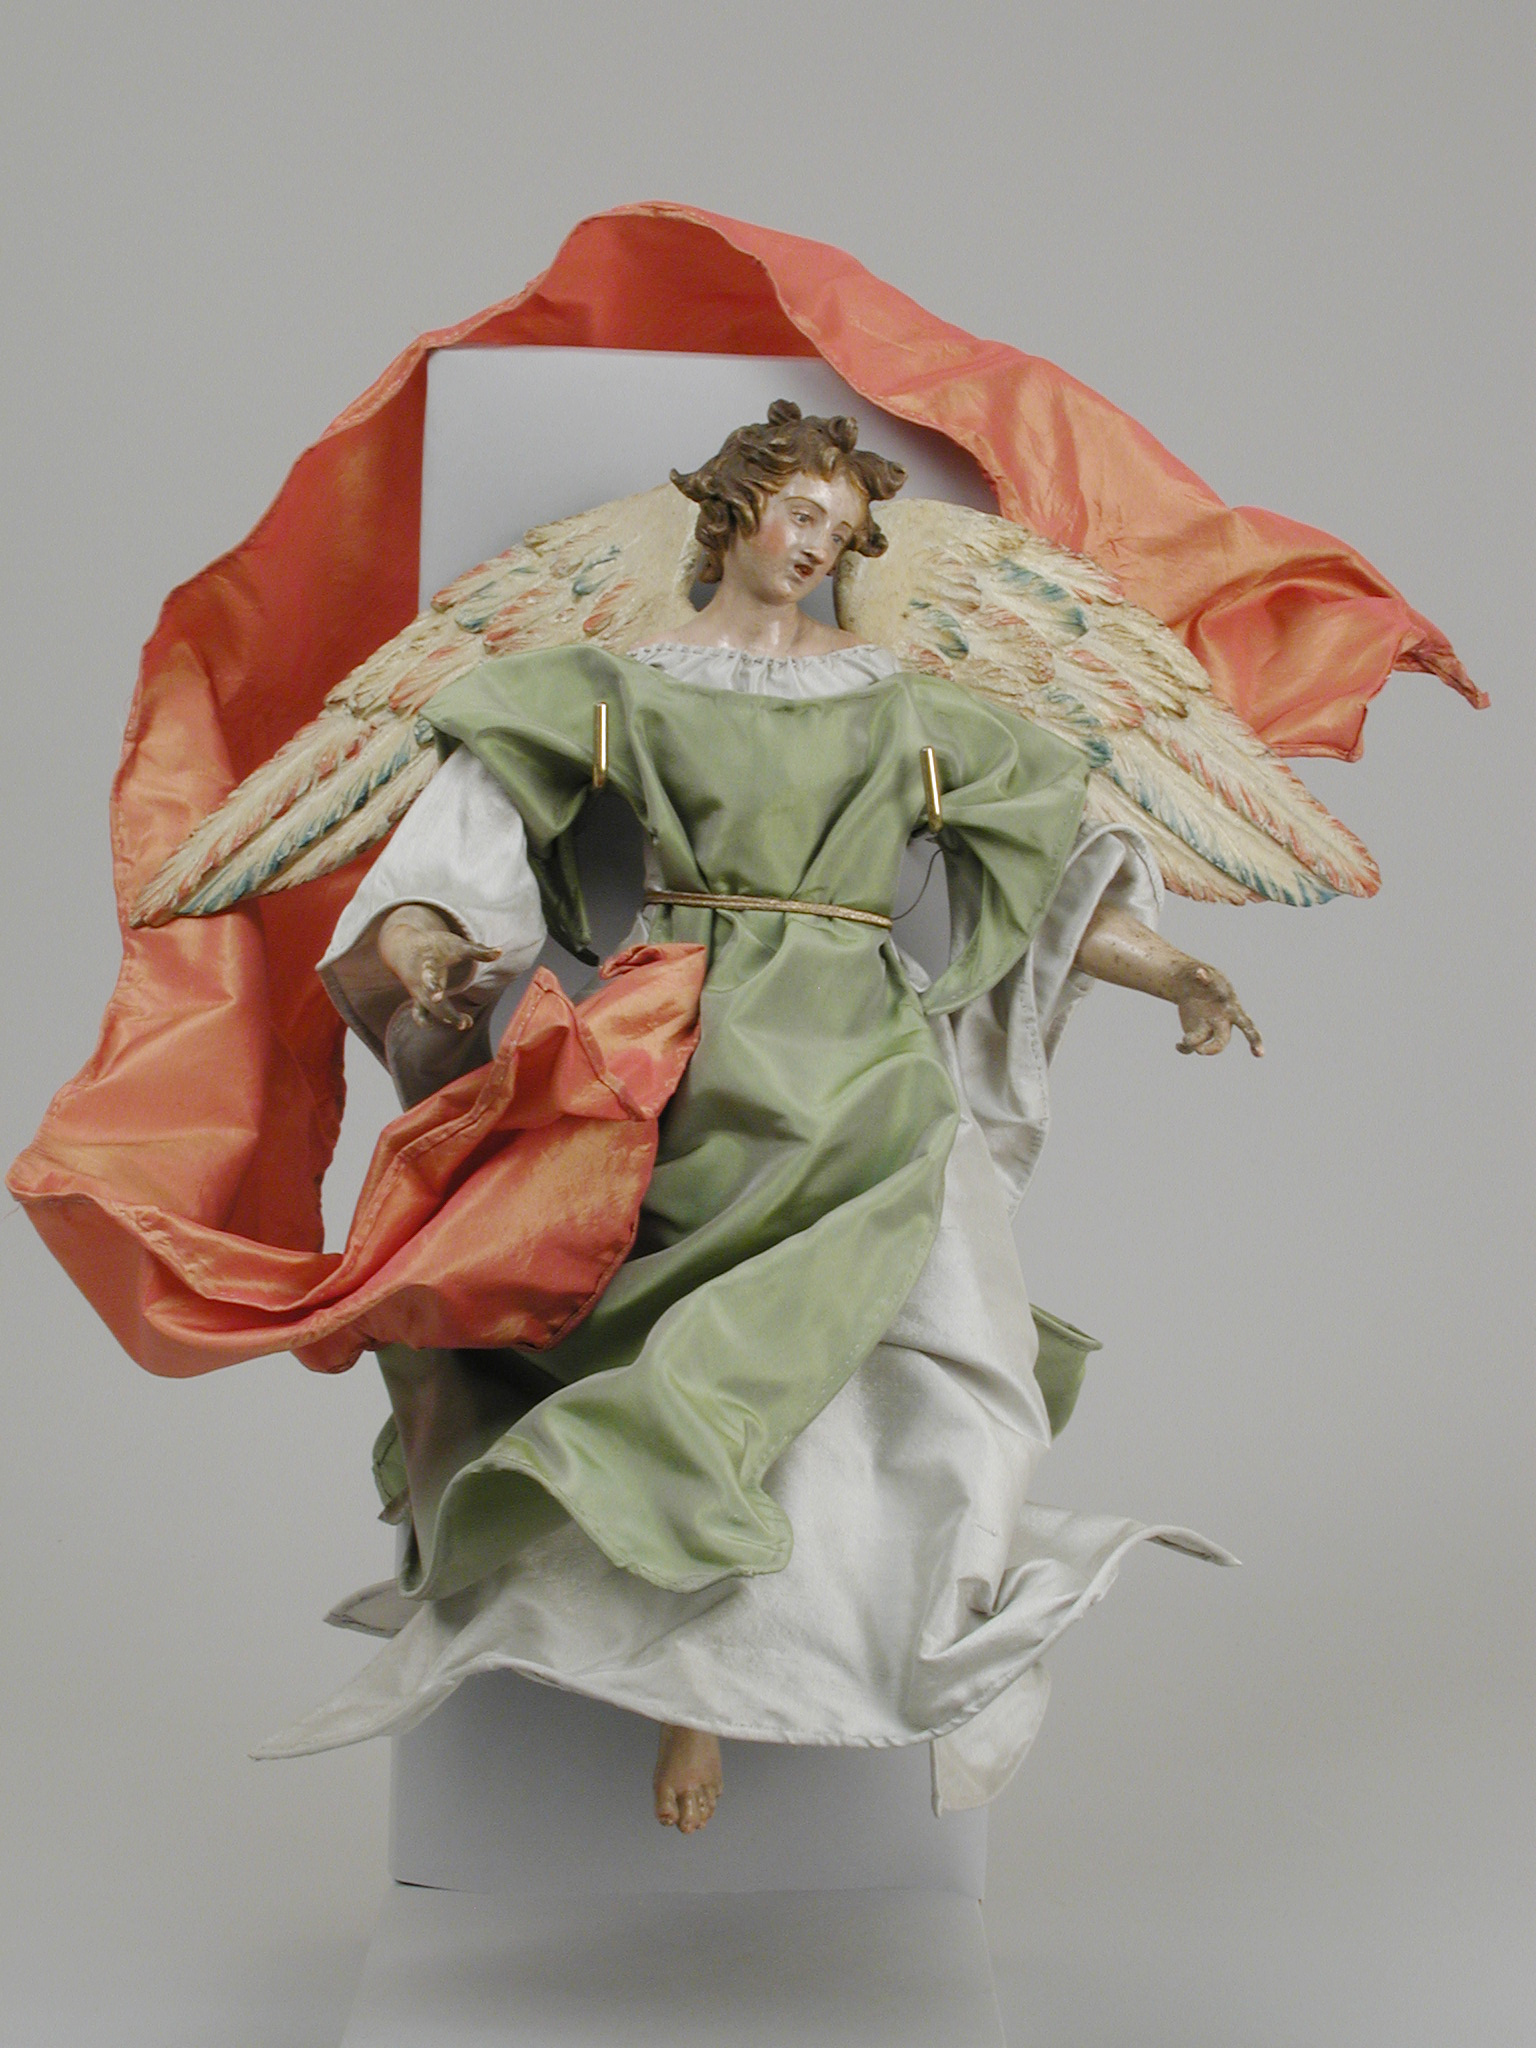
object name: crèche figure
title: Angel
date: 1751-1800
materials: terracotta, fiber, metal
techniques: polychrome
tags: angels